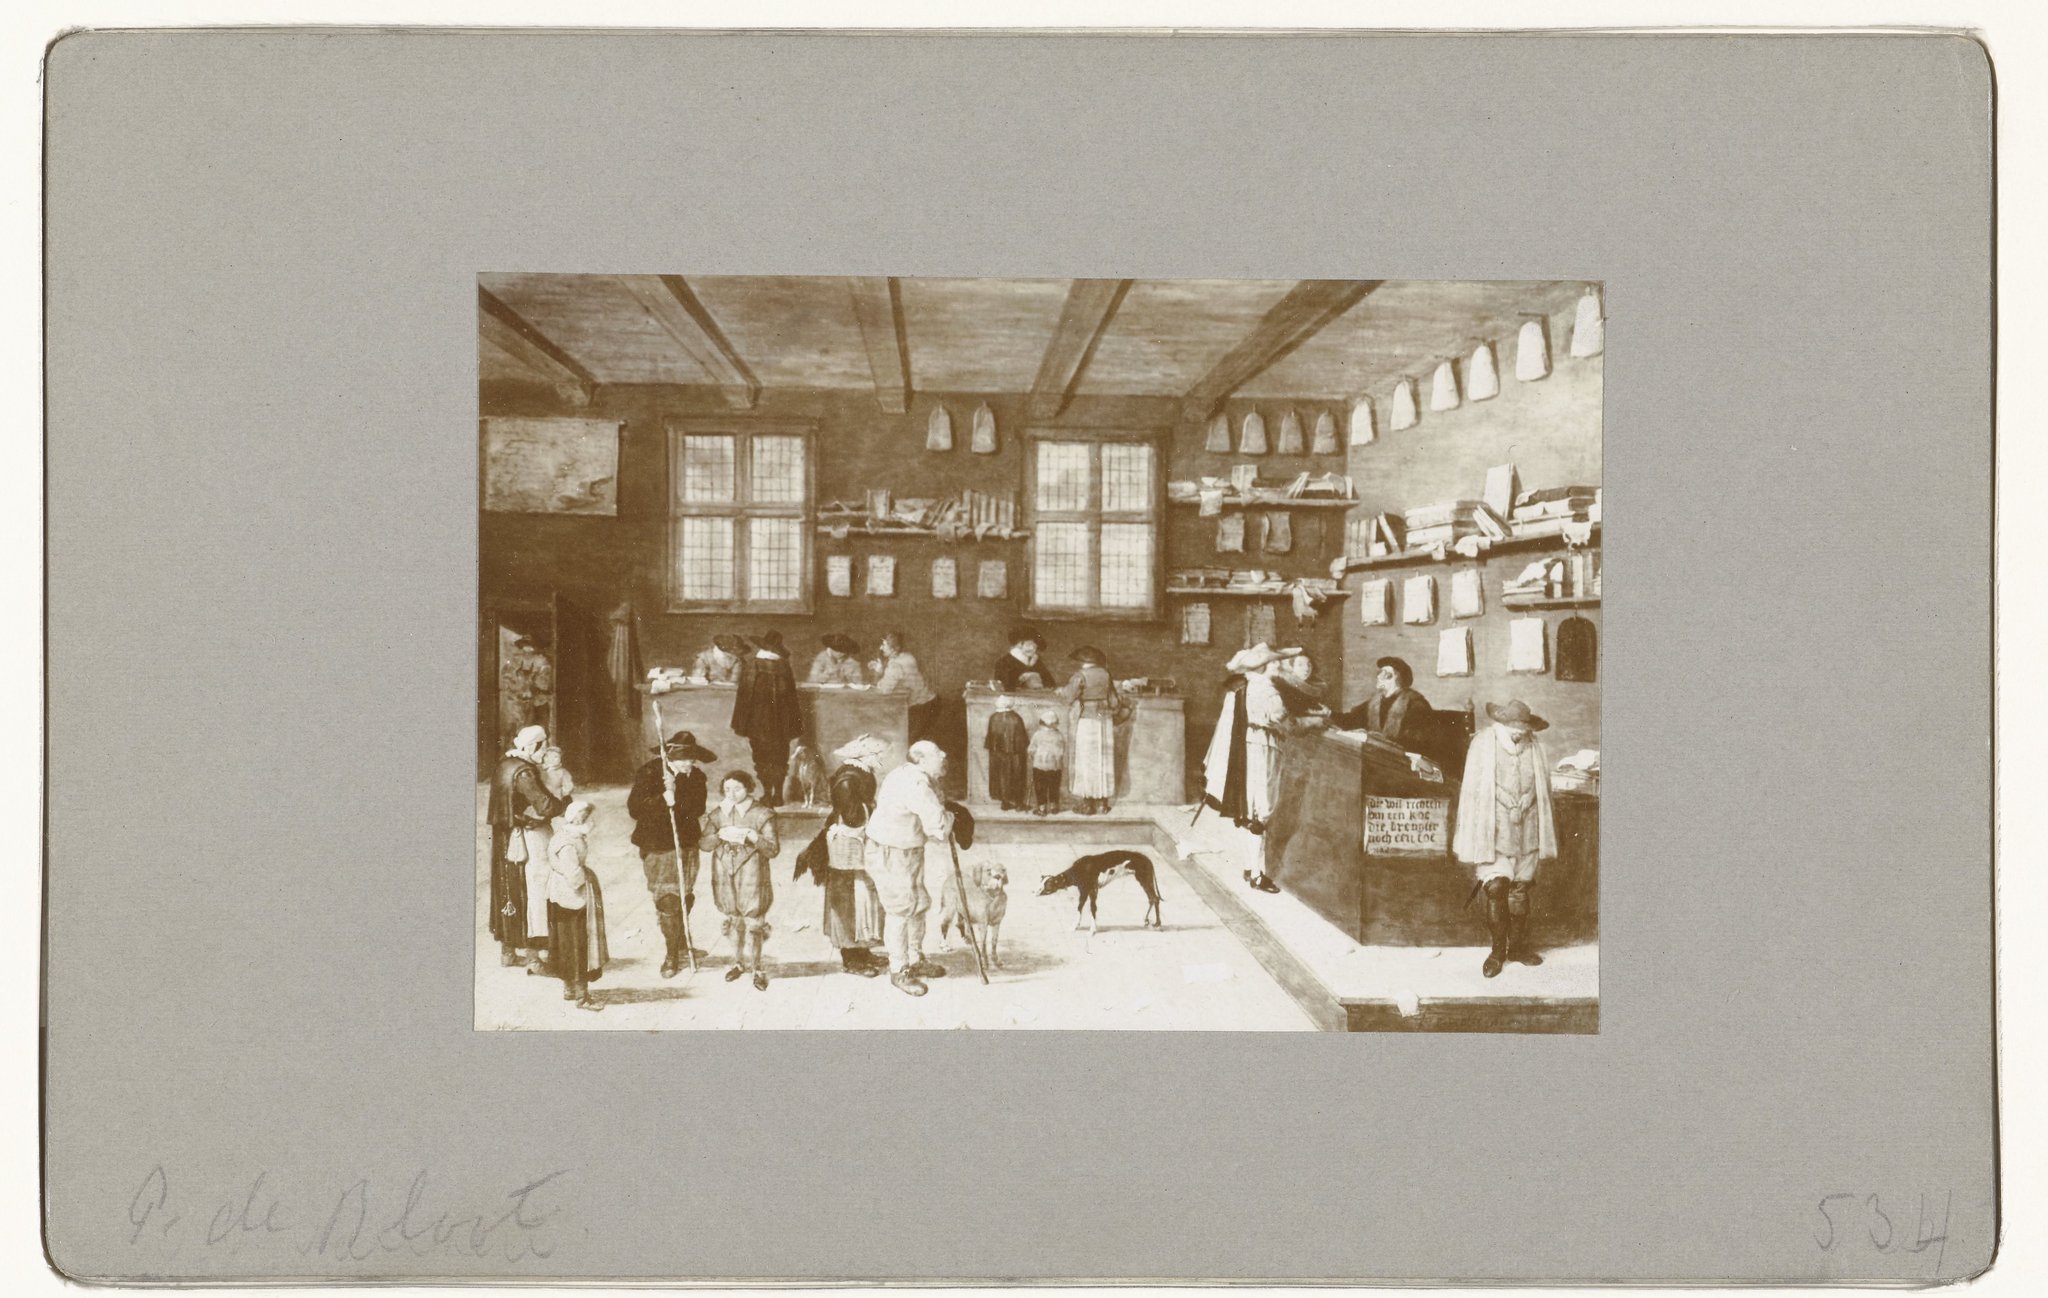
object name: photograph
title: Schilderij Het kantoor van de advocaat door Pieter de Bloot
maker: dora de gijselaar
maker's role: fotograaf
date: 1915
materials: cardboard, paper, photographic support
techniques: gelatin silver print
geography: amsterdam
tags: picture, painting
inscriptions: name: ‘Vervaardigd door Mej. Dora de Gijselaar, Lichtbeeldenvereeniging Spui 23 Amsterdam’, annotation: ‘Car No 534 P.P. de Bloot, Het kantoor van den Advocaat’